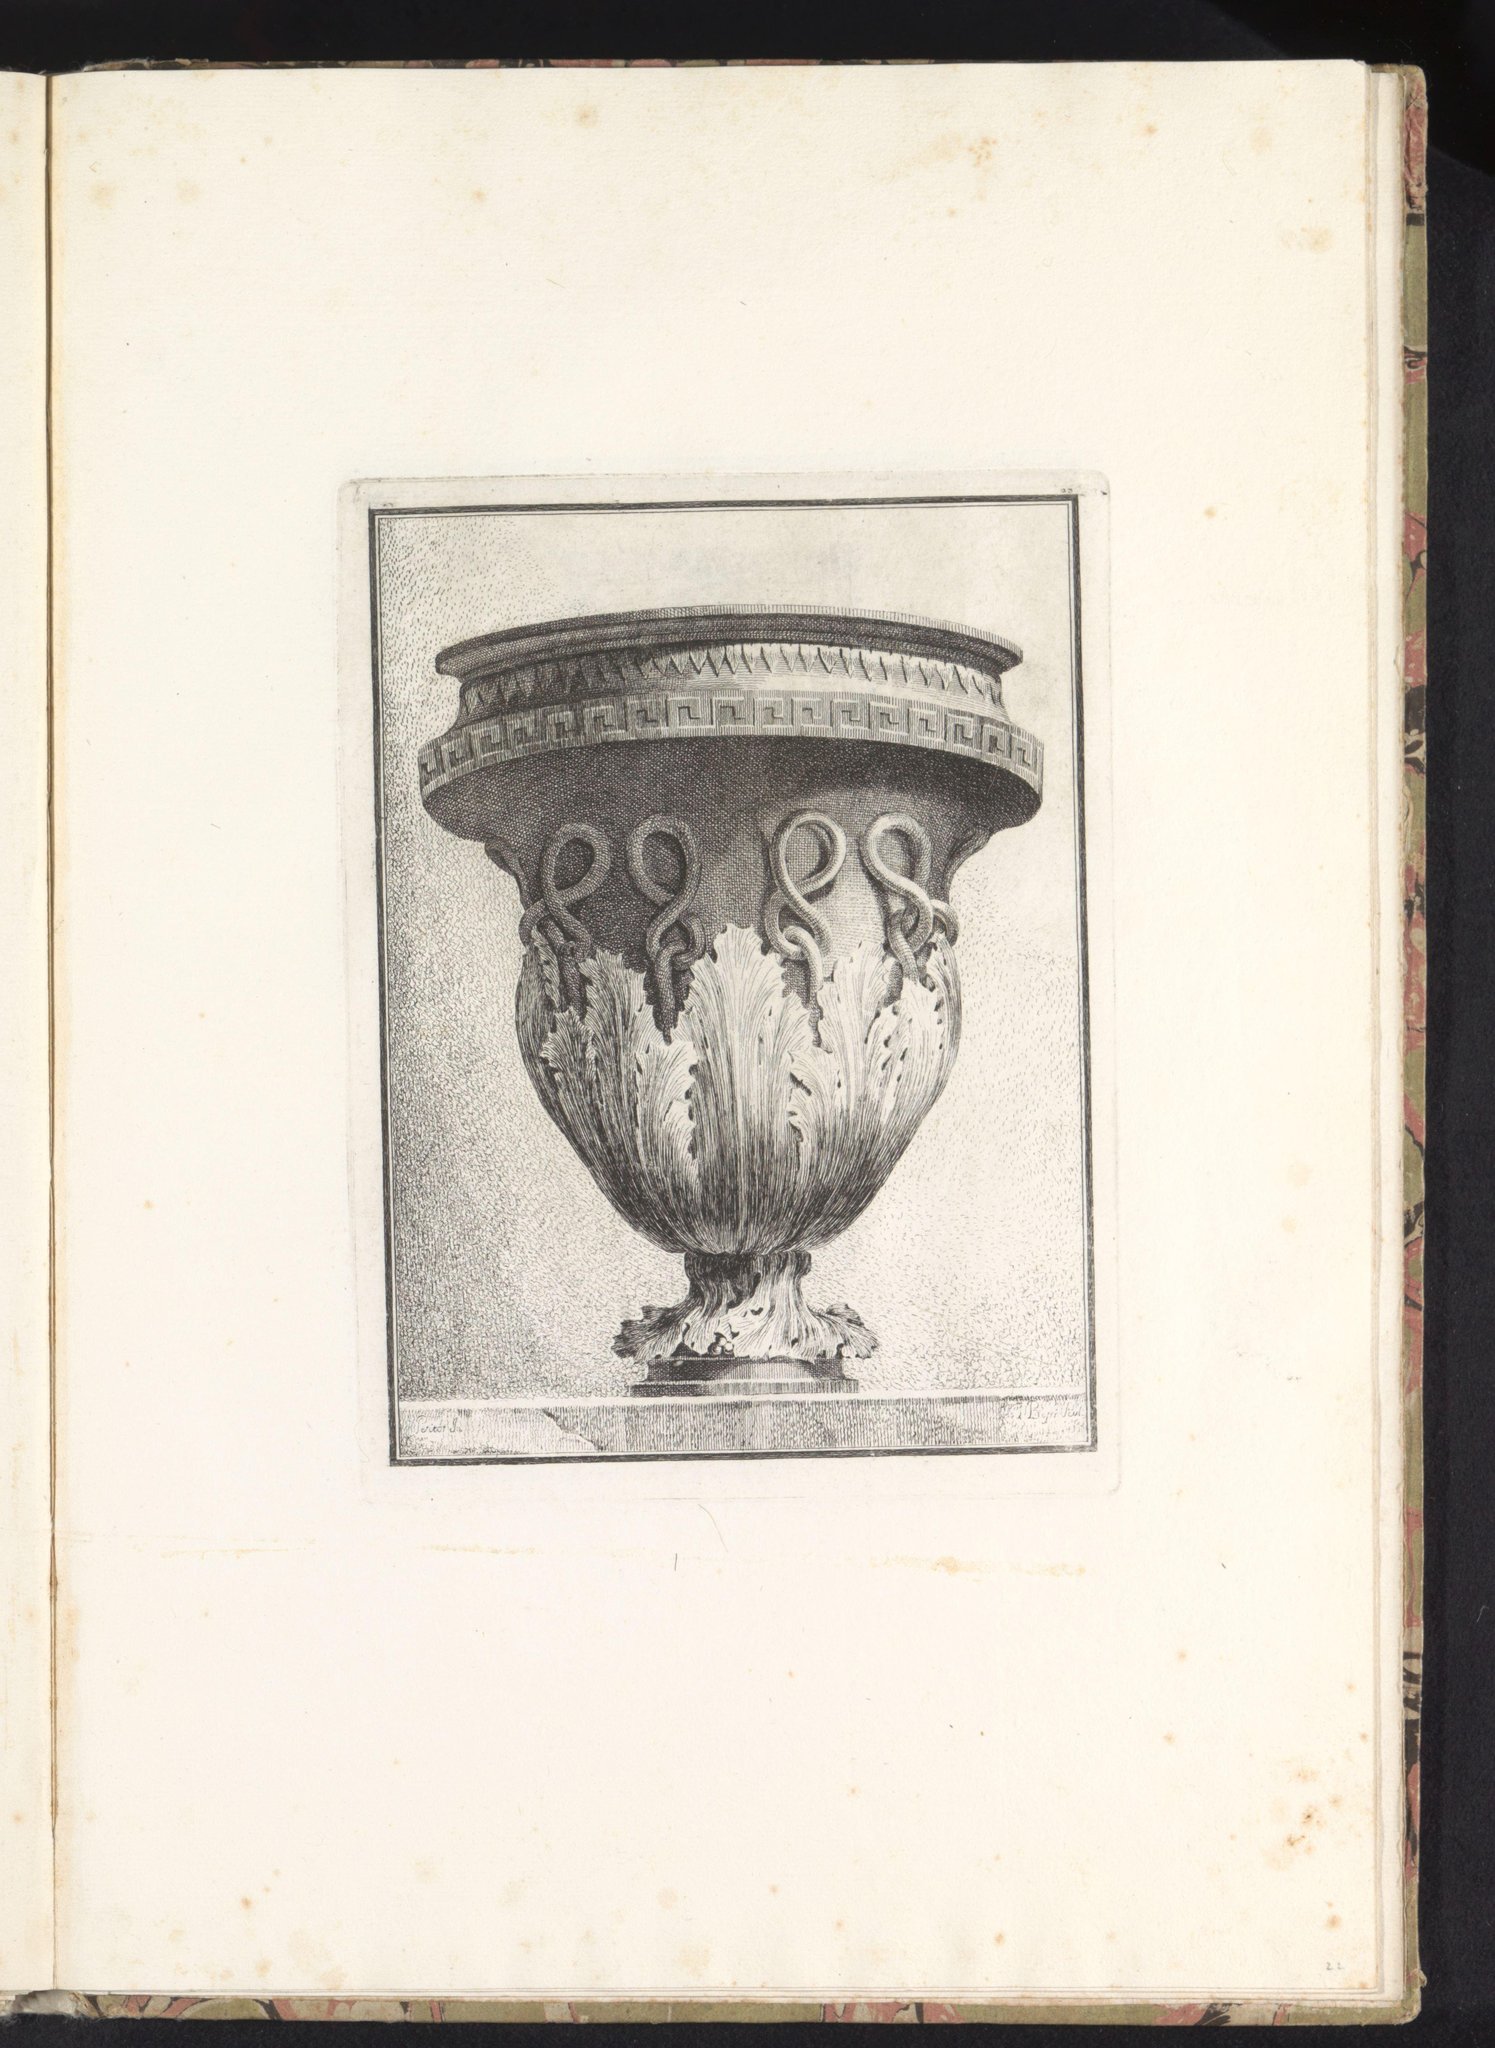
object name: ornament print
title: Ornamentele vazen uit de collectie van Guillaume du Tillot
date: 1764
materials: paper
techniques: etching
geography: parma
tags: snakes, vase ~ ornament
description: Vaas waarvan de voet en de buik zijn gedecoreerd met acanthusbladeren, hierboven slangmotief. De hals is afgezet met een band met meander en bladmotief. No. 23 uit serie van 31. Prent maakt deel uit van een album. Gedrukt recto rechtsboven: 23.